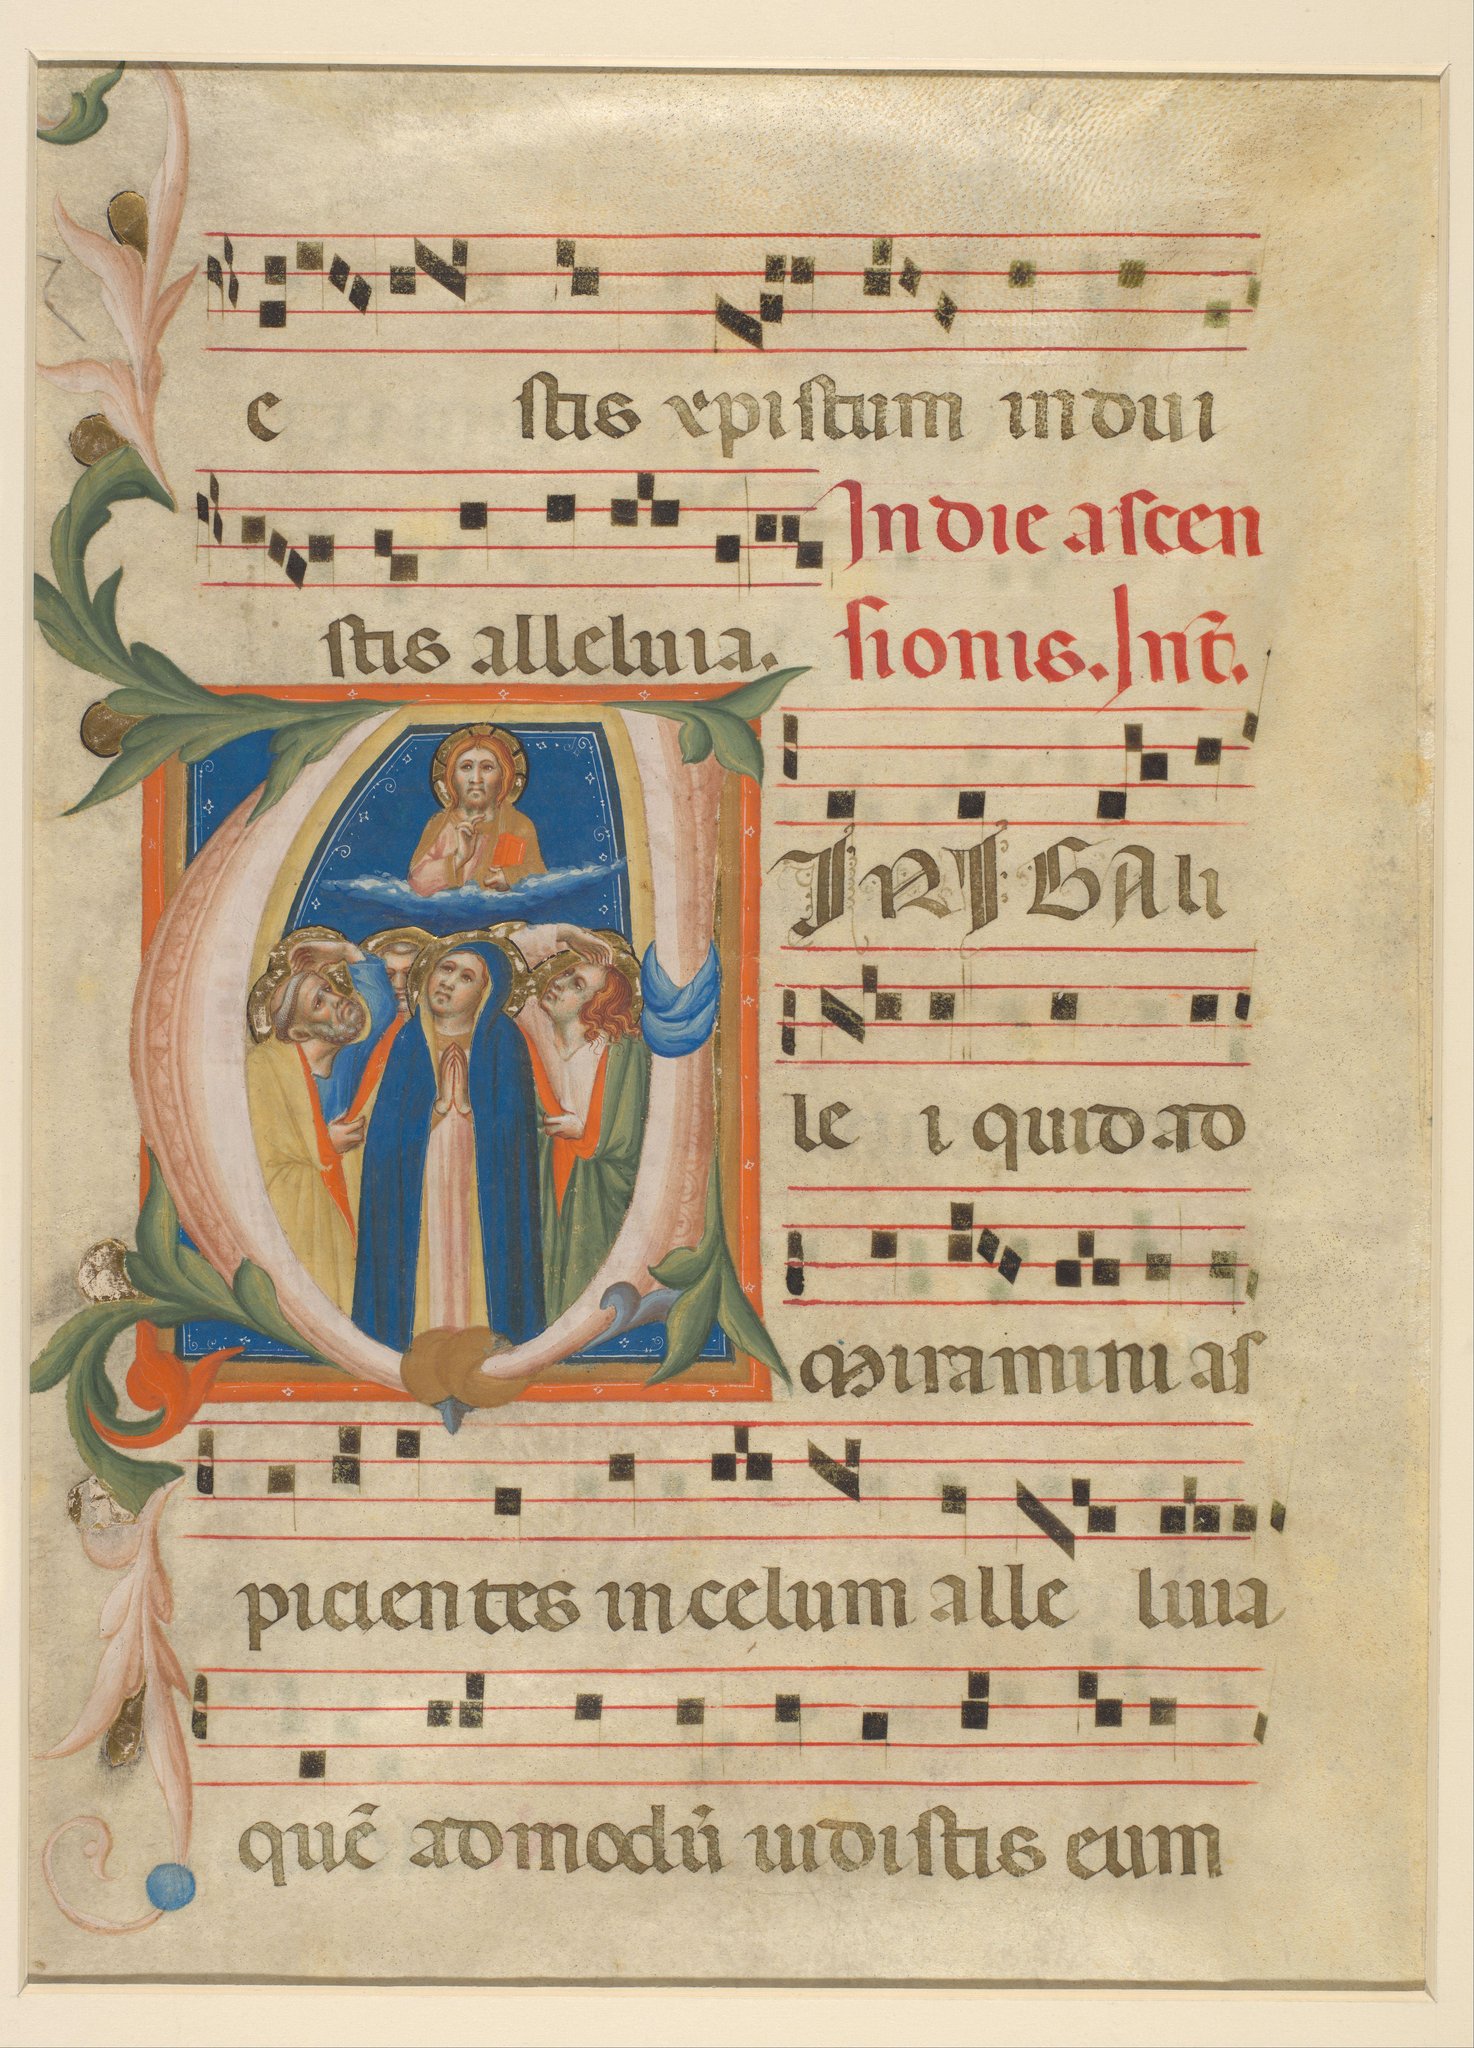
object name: drawing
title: Fragment van een missaal: initiaal A met hemelvaart van Christus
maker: lippo vanni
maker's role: draughtsman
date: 1342-1346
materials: paint, gold leaf, ink, parchment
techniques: brush, pen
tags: the ascension (christ surrounded by radiant light or in a mandorla), manuscript of musical score, historiated initial